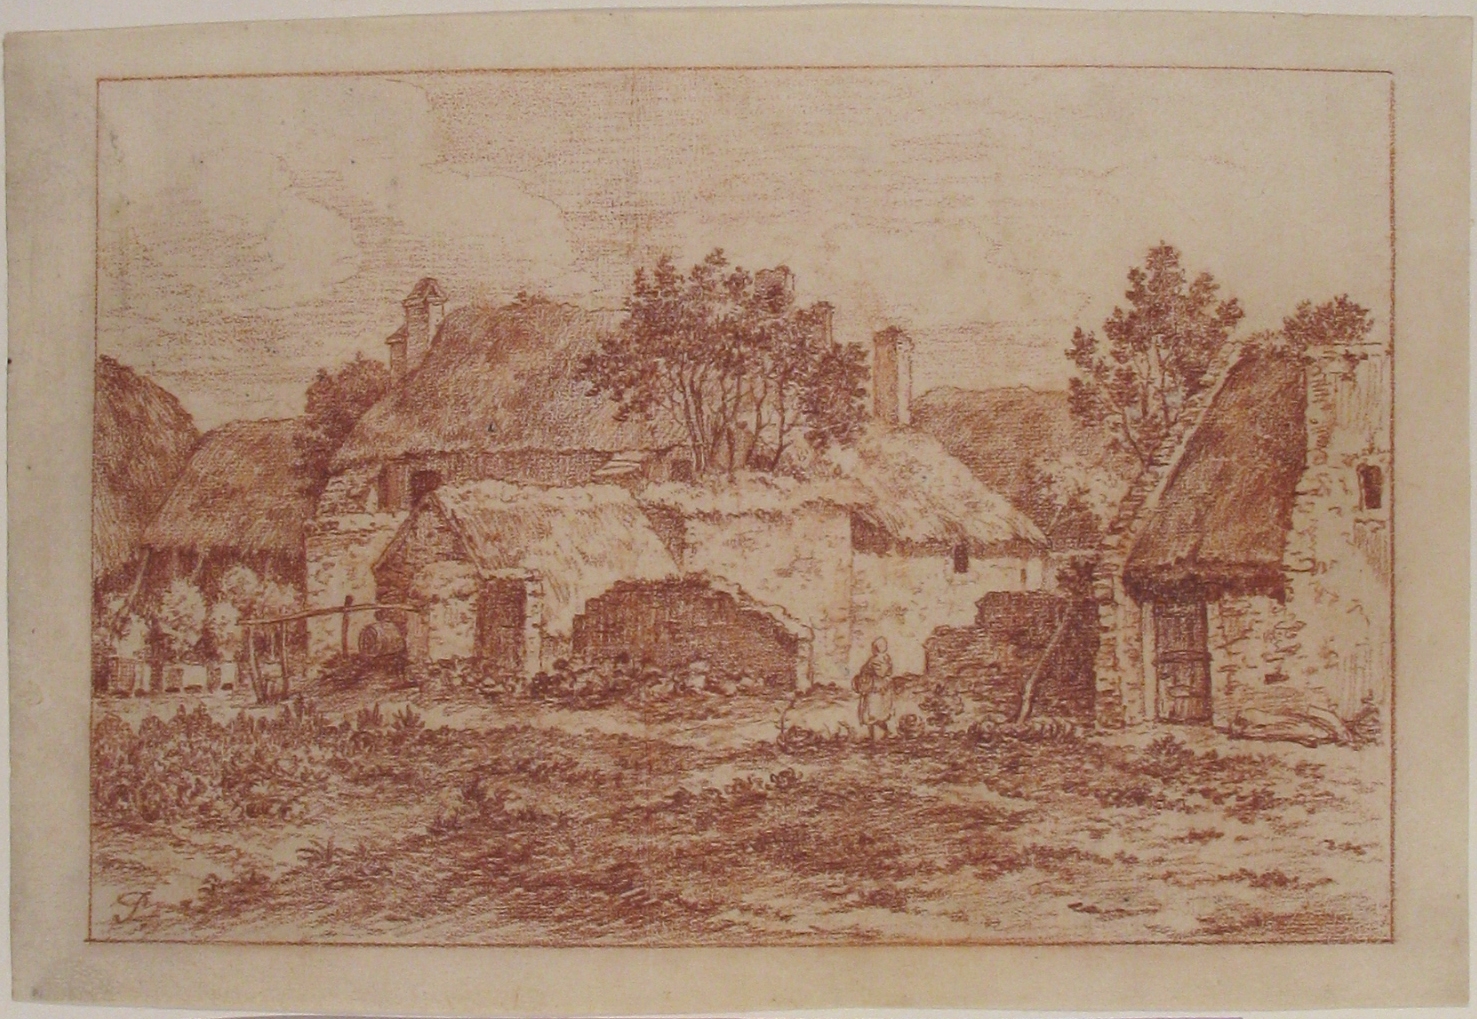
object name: drawing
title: Landscape With a Farmyard, Thatched-Roofed Buildings and a Peasant Woman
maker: anonymous, french, 18th century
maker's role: artist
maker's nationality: french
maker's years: 1700-1800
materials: chalk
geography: france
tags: buildings,houses,roofs,farms,women